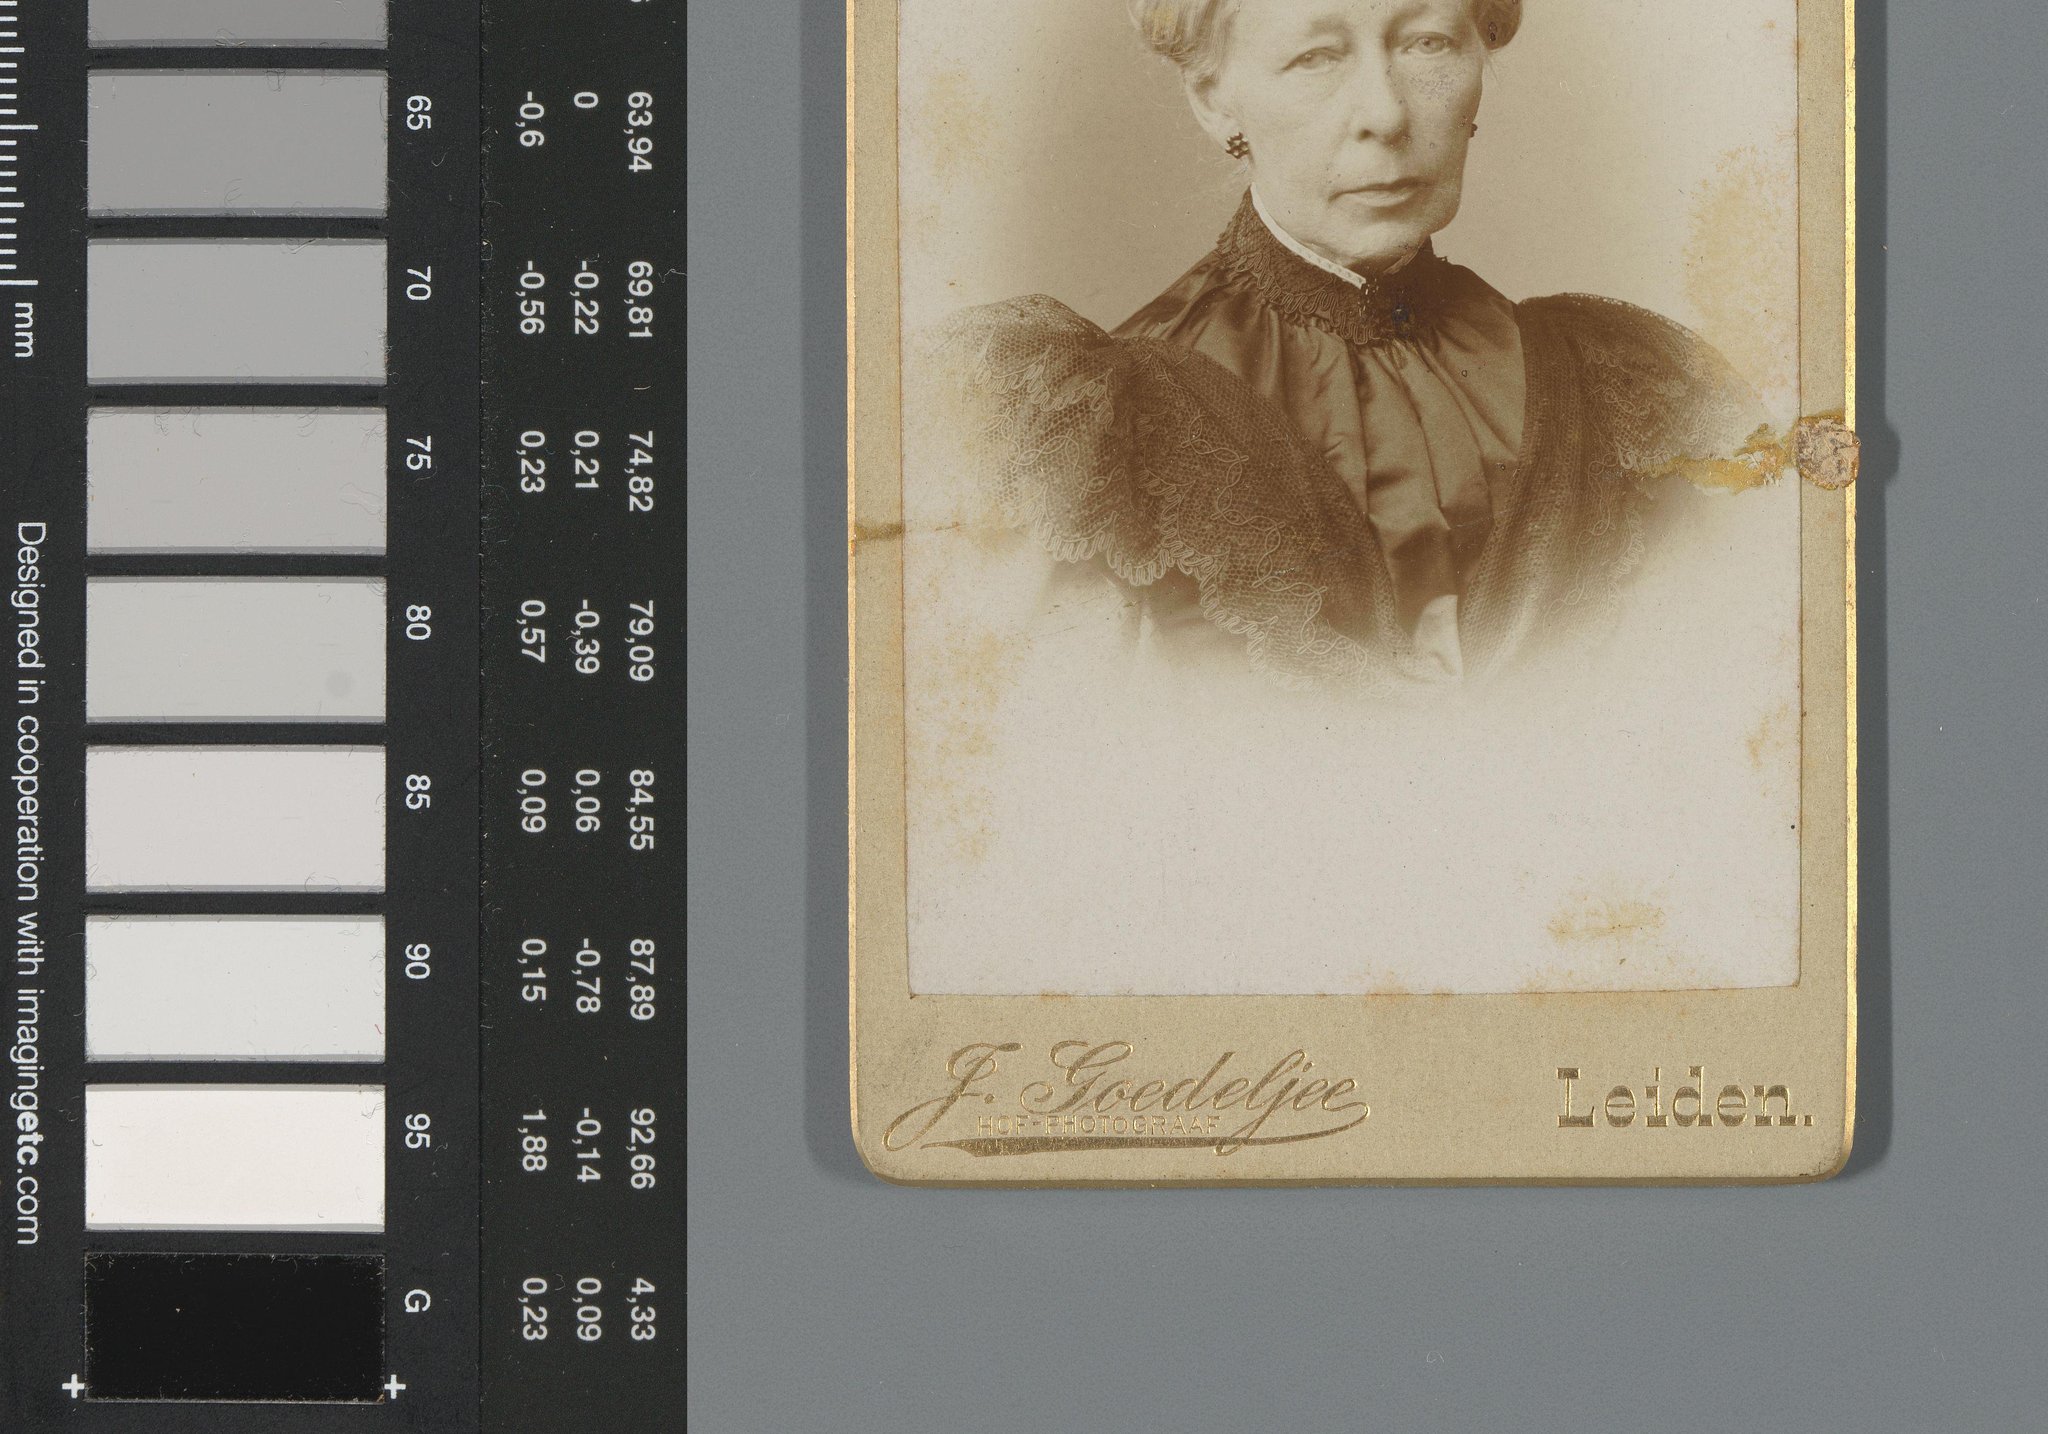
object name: carte de visite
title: Portret van Cornelia Maria Leemans-De Virieu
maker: jan goedeljee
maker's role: fotograaf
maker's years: 1824-1905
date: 1874-1904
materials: cardboard, photographic support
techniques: photography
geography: leiden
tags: leiden, historical persons - bb - woman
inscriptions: annotation: ‘Keni Leemans-de Virieu’